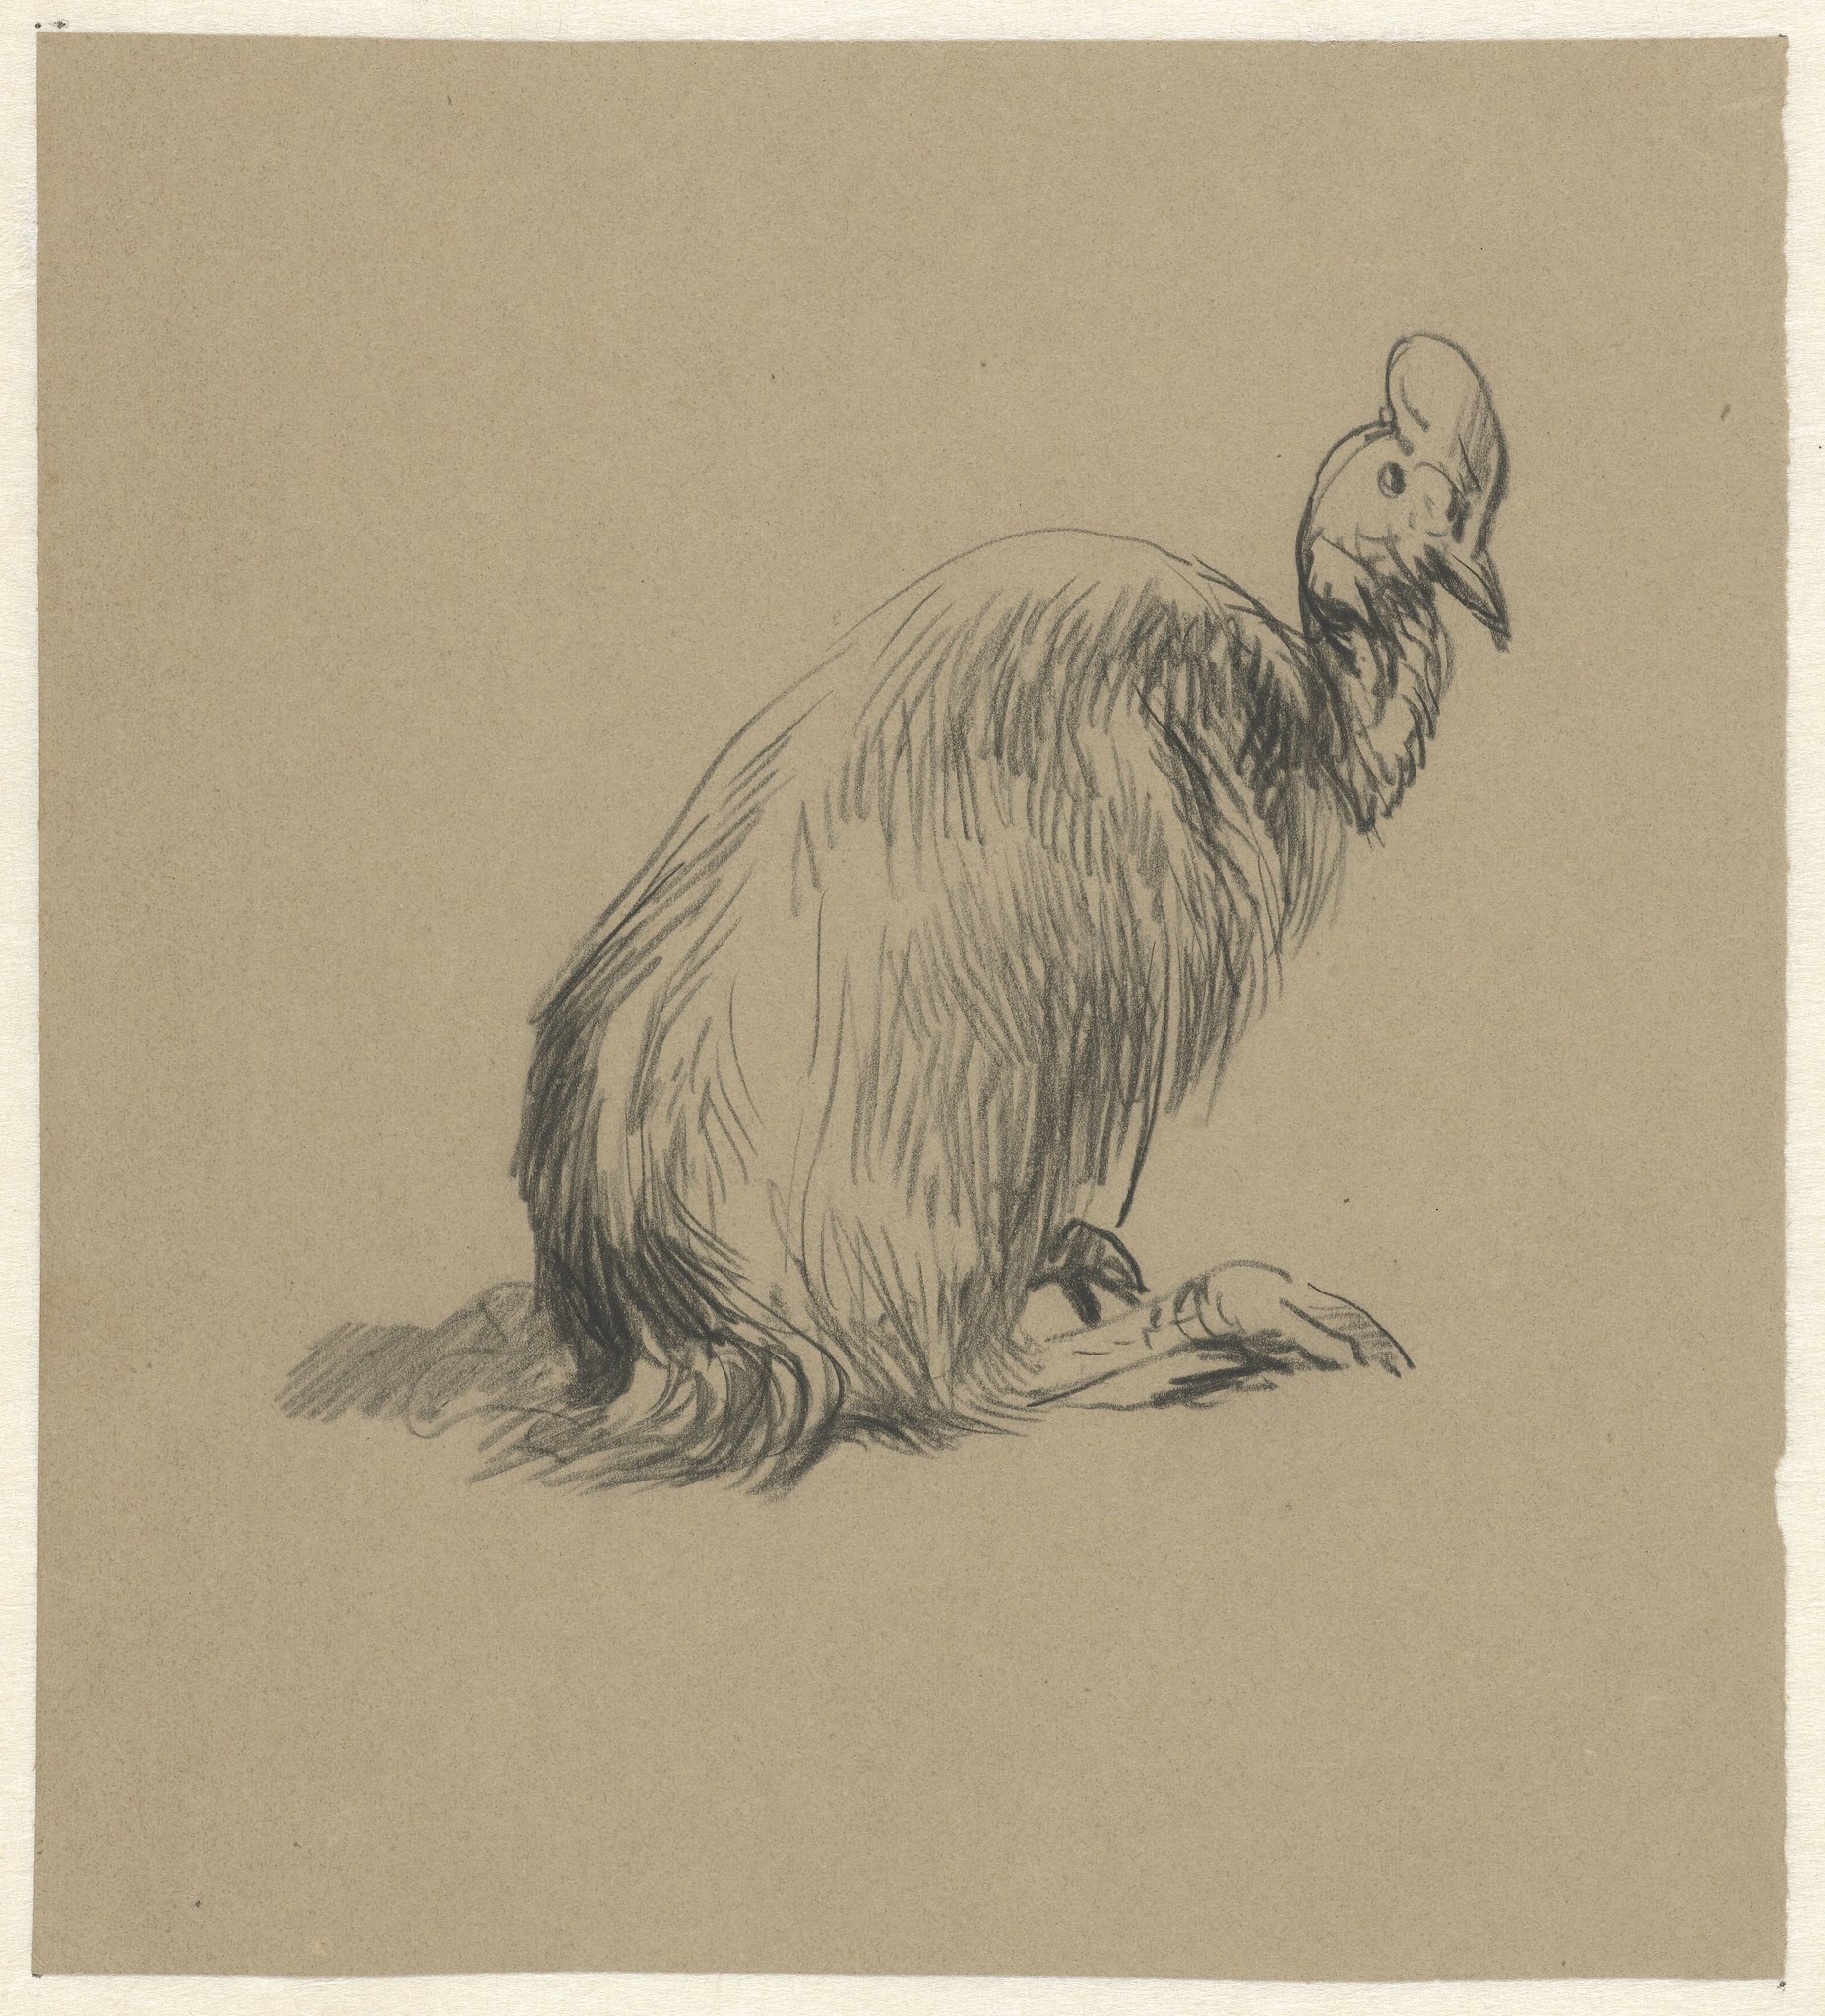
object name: drawing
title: Kasuaris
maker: guillaume anne van der brugghen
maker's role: draughtsman, print maker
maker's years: 1812-1891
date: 1821-1891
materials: chalk, paper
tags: walker and runner birds: cassowary